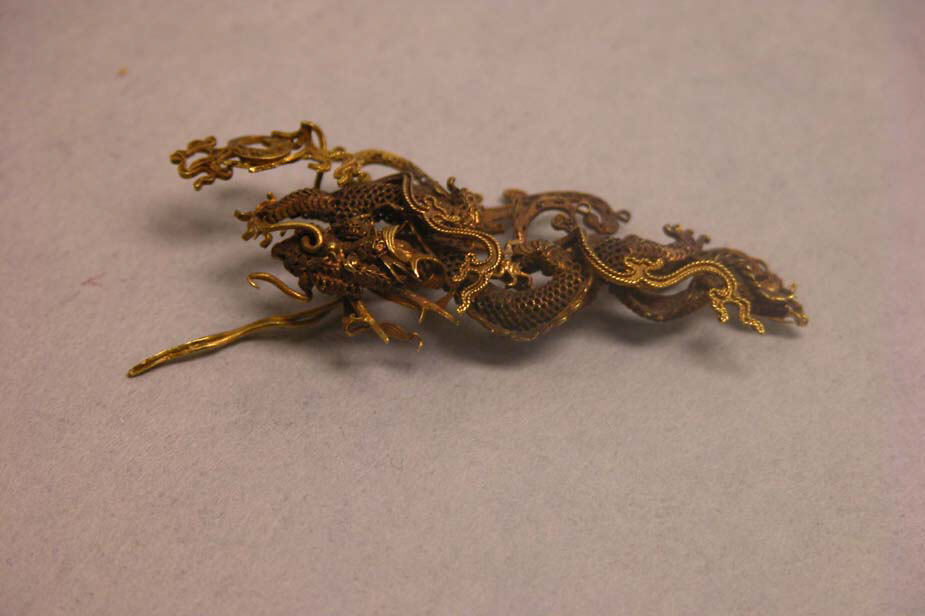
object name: ornament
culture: chinese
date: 960-1279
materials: gold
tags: dragons